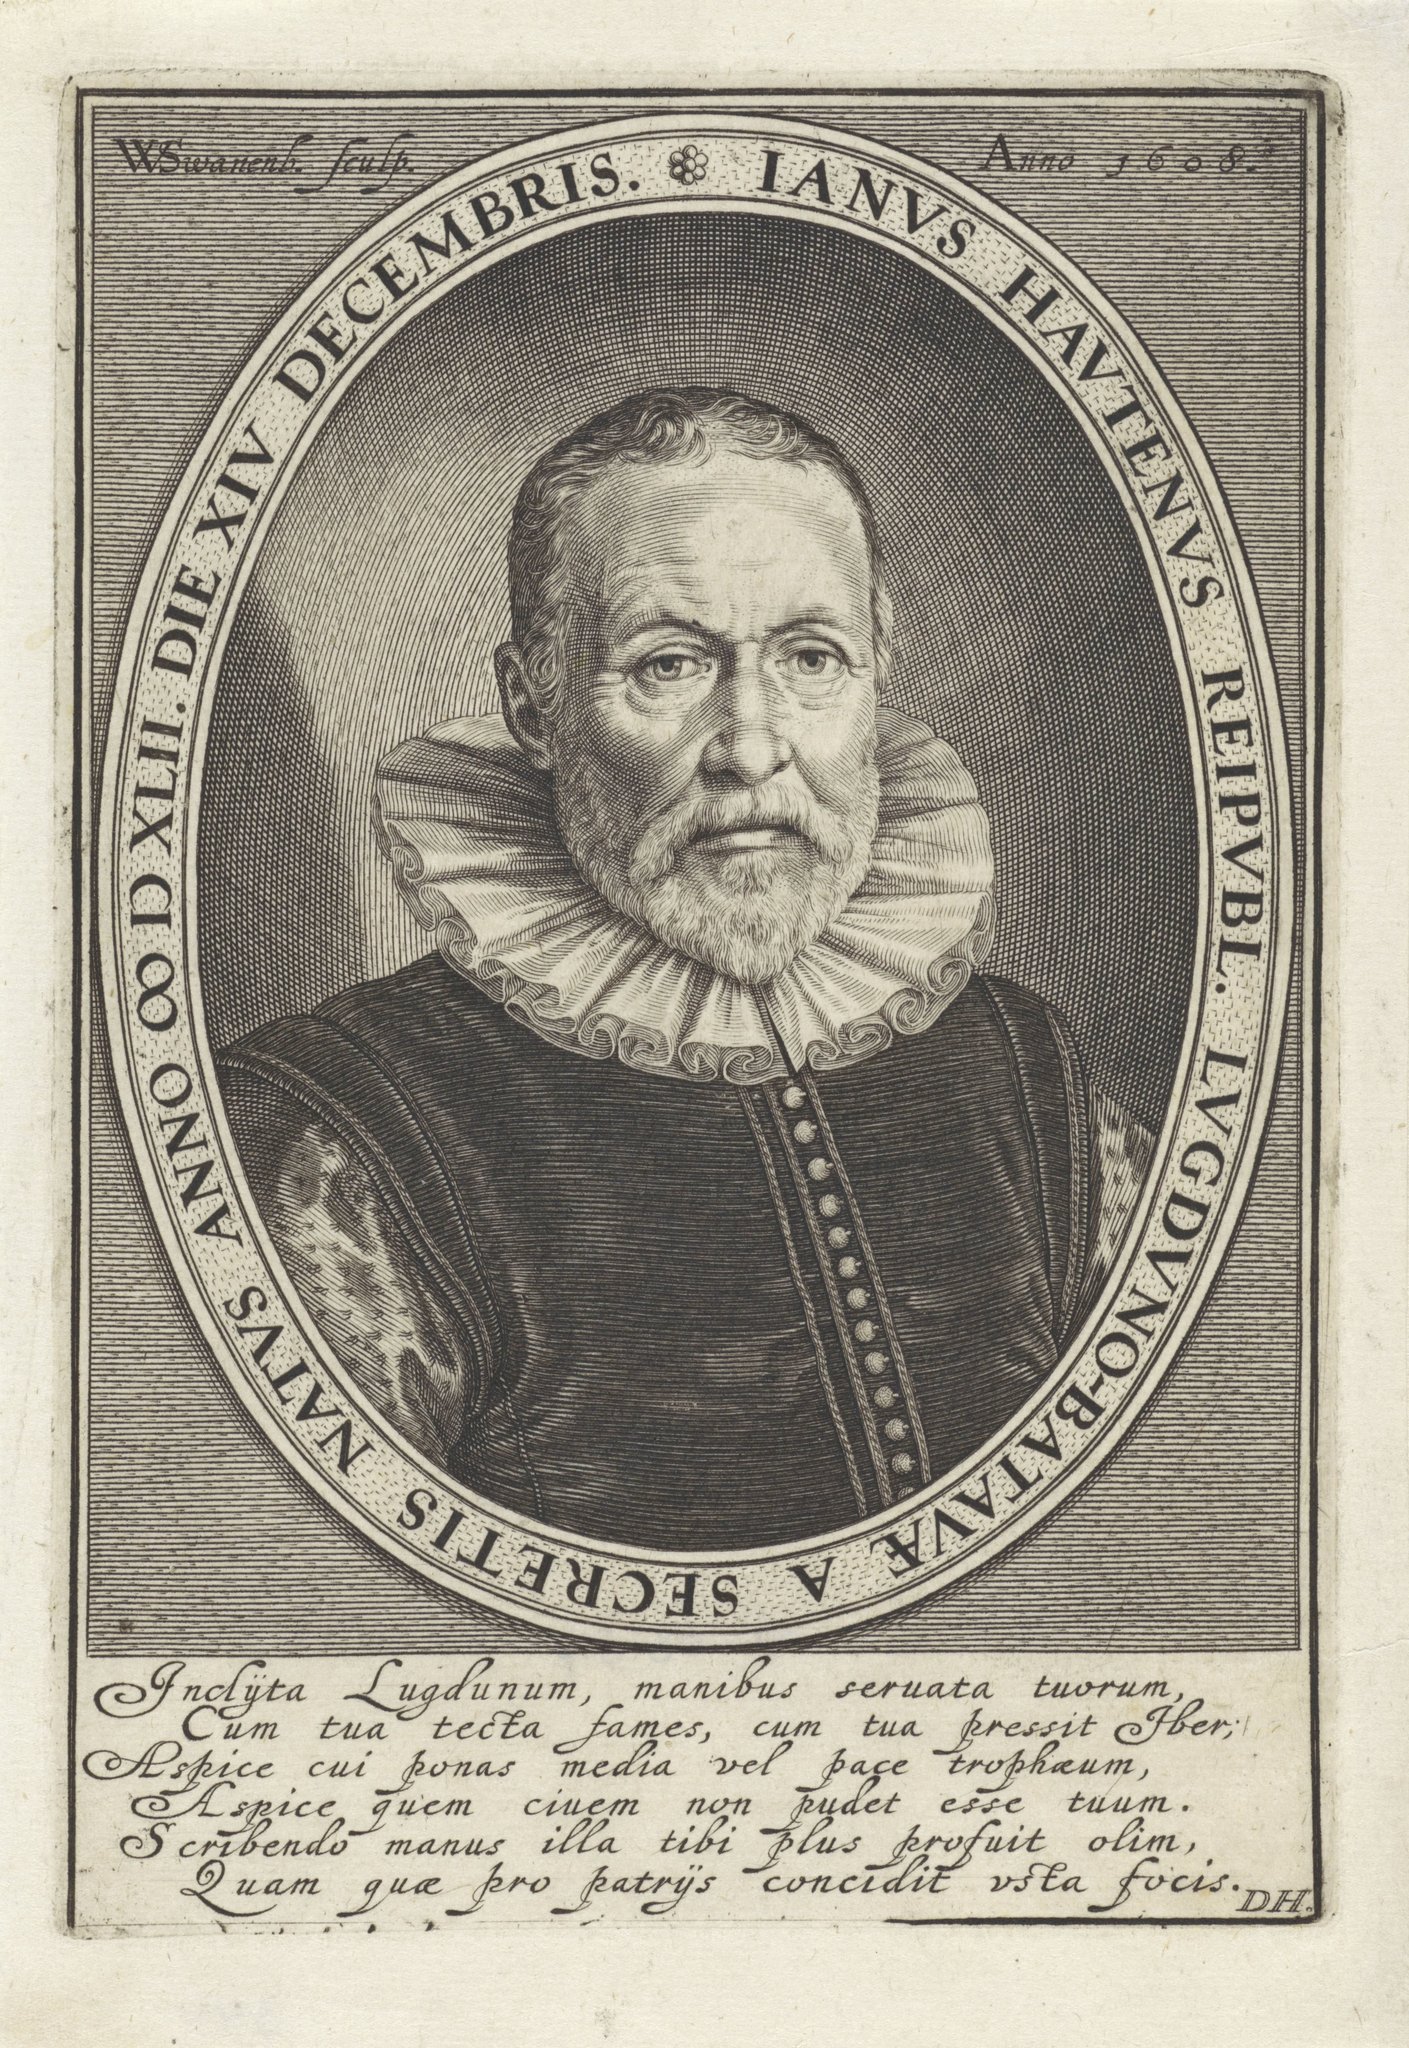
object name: print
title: Portret van Jan van Hout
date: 1608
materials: paper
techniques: engraving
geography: leiden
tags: leiden, portrait of a writer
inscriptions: collector's mark: Lugt 2228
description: Portret van Jan van Hout, secretaris van de stad Leiden. Onder het portret een zesregelige tekst in het Latijn.